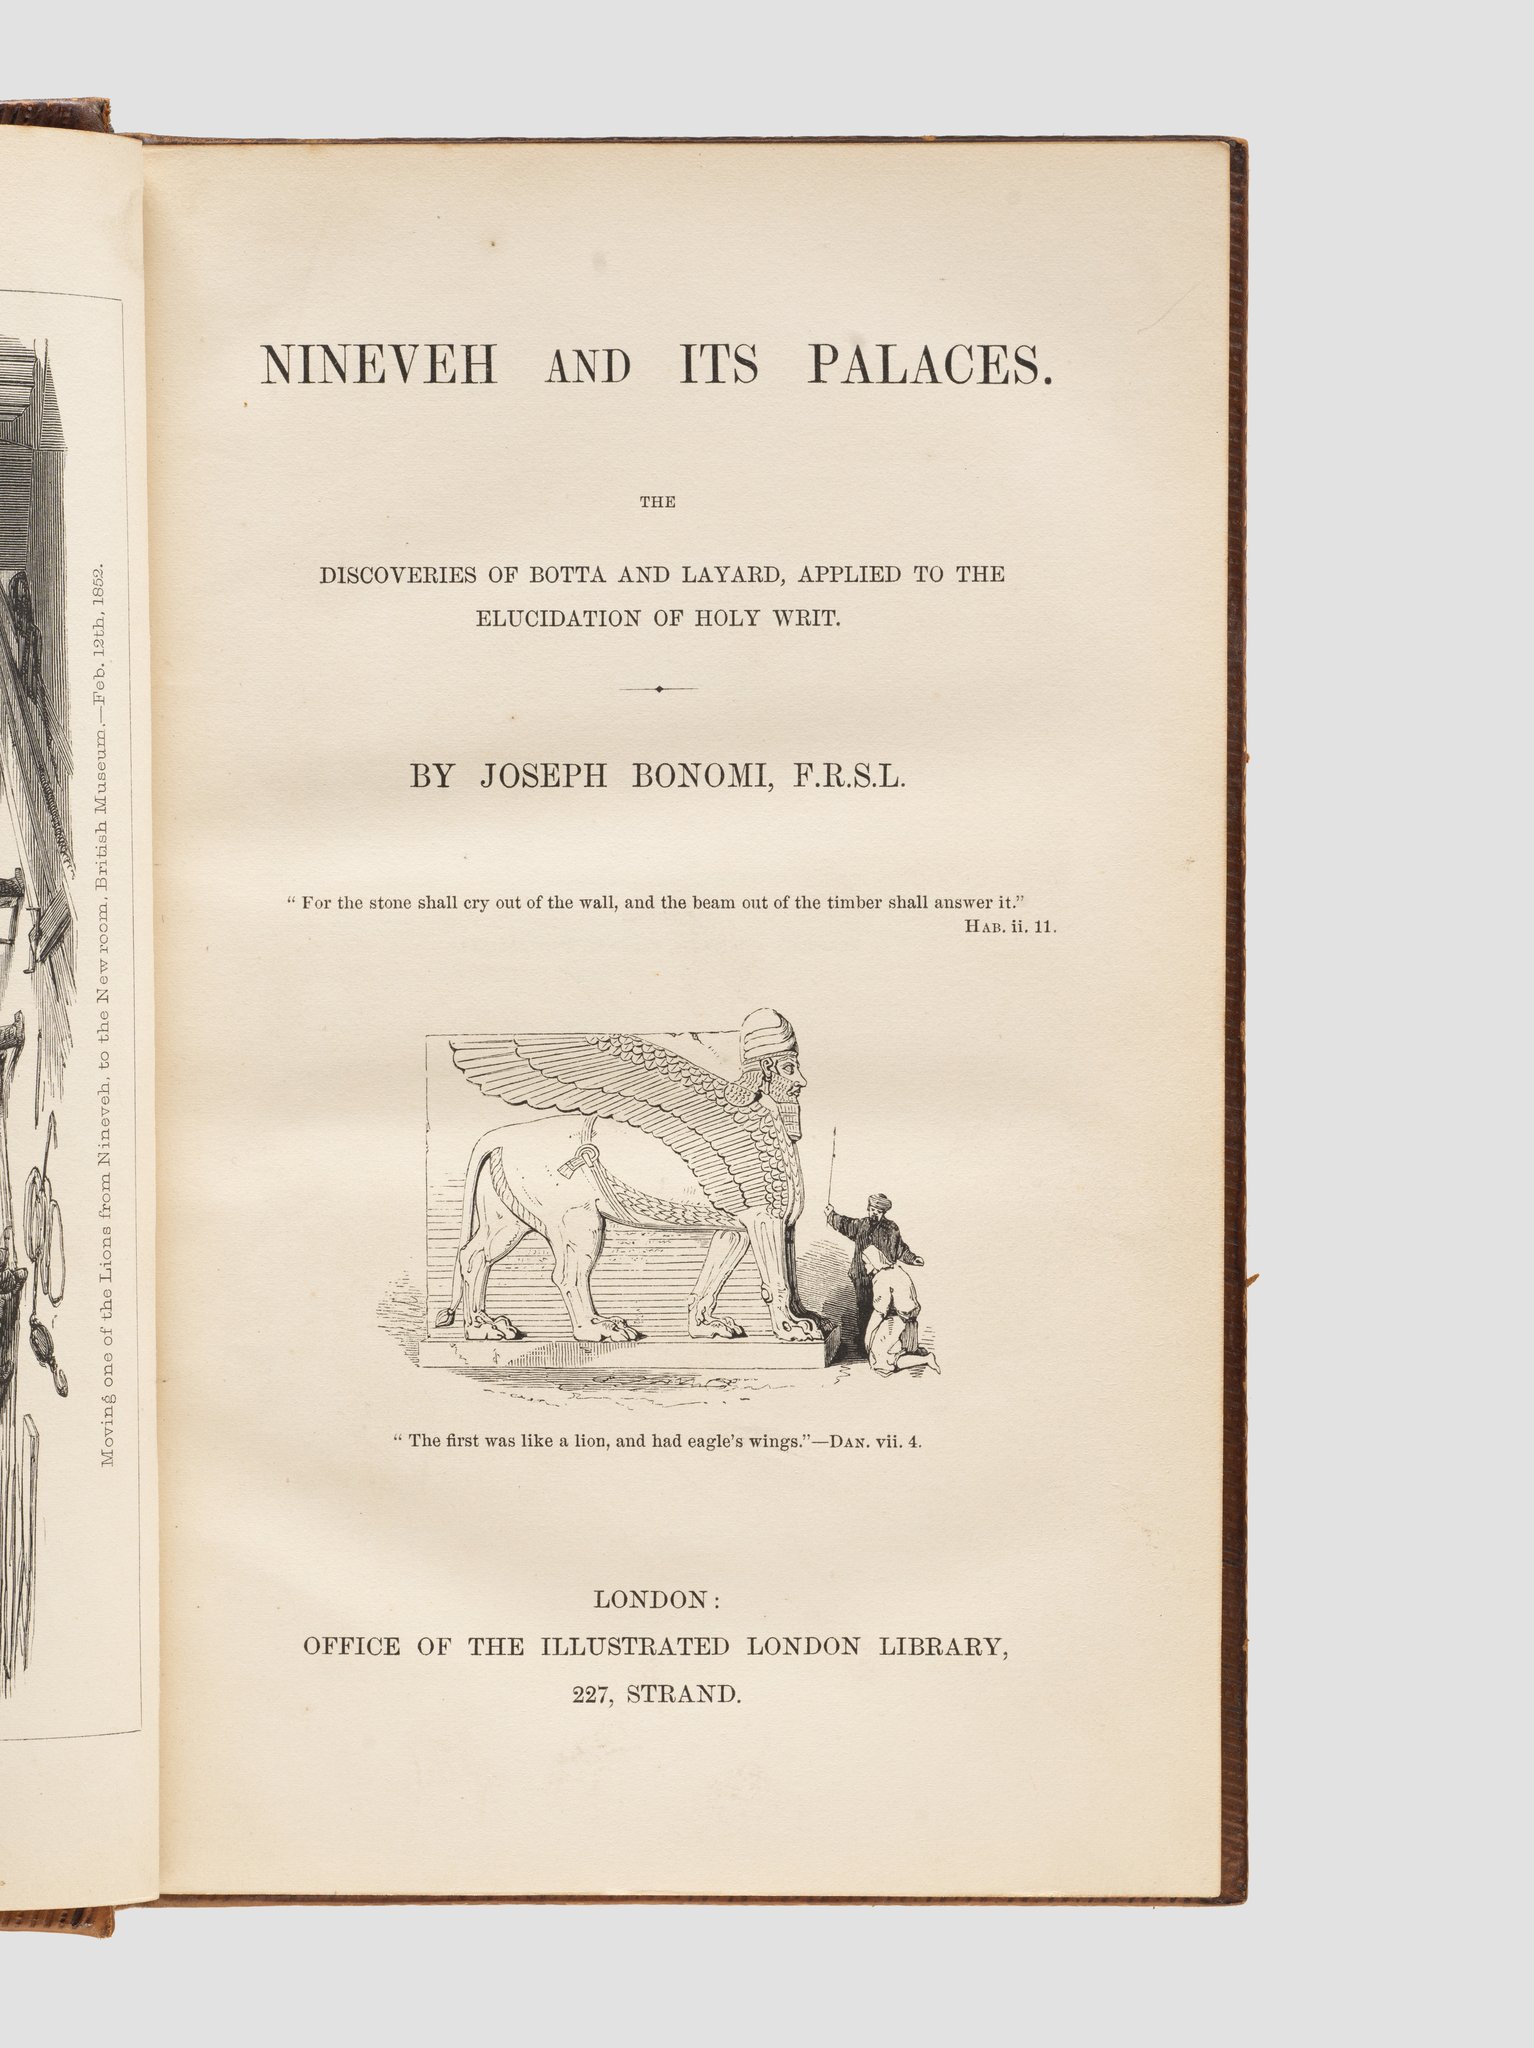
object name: book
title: Nineveh and Its Palaces: The Discoveries of Botta and Layard, Applied to the Elucidation of Holy Writ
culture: british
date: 1852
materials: board, leather, paper